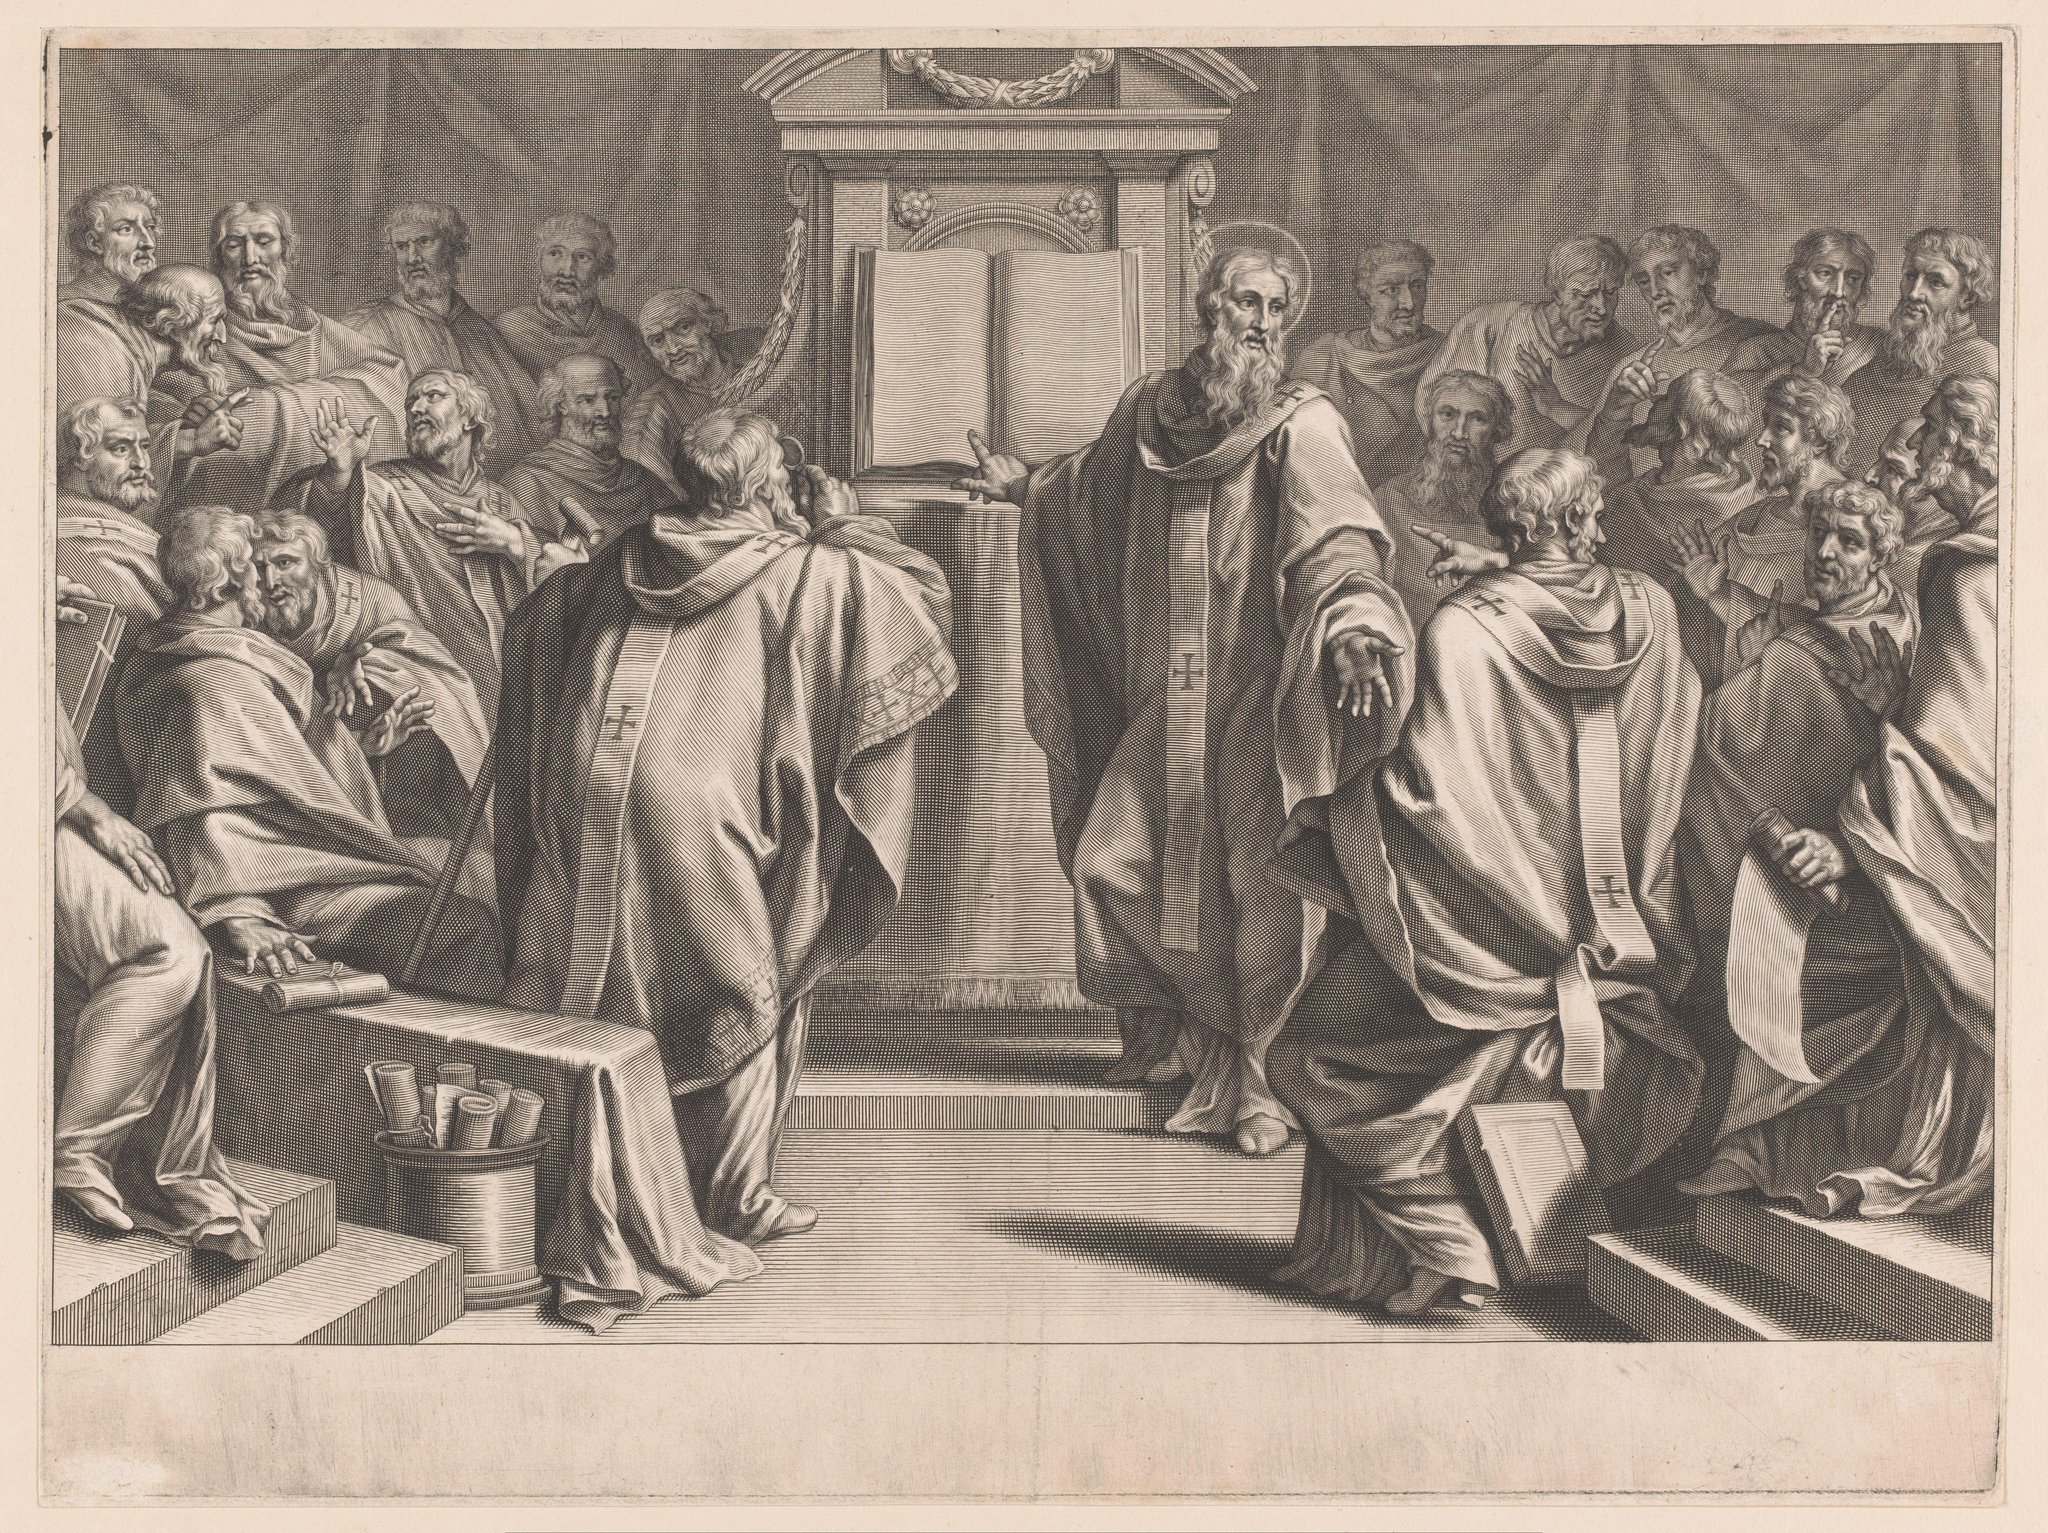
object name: print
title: Concilie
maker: Anonymous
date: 1700-1899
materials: paper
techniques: engraving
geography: france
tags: council, synod ~ roman catholic church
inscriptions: collector's mark: Lugt 240